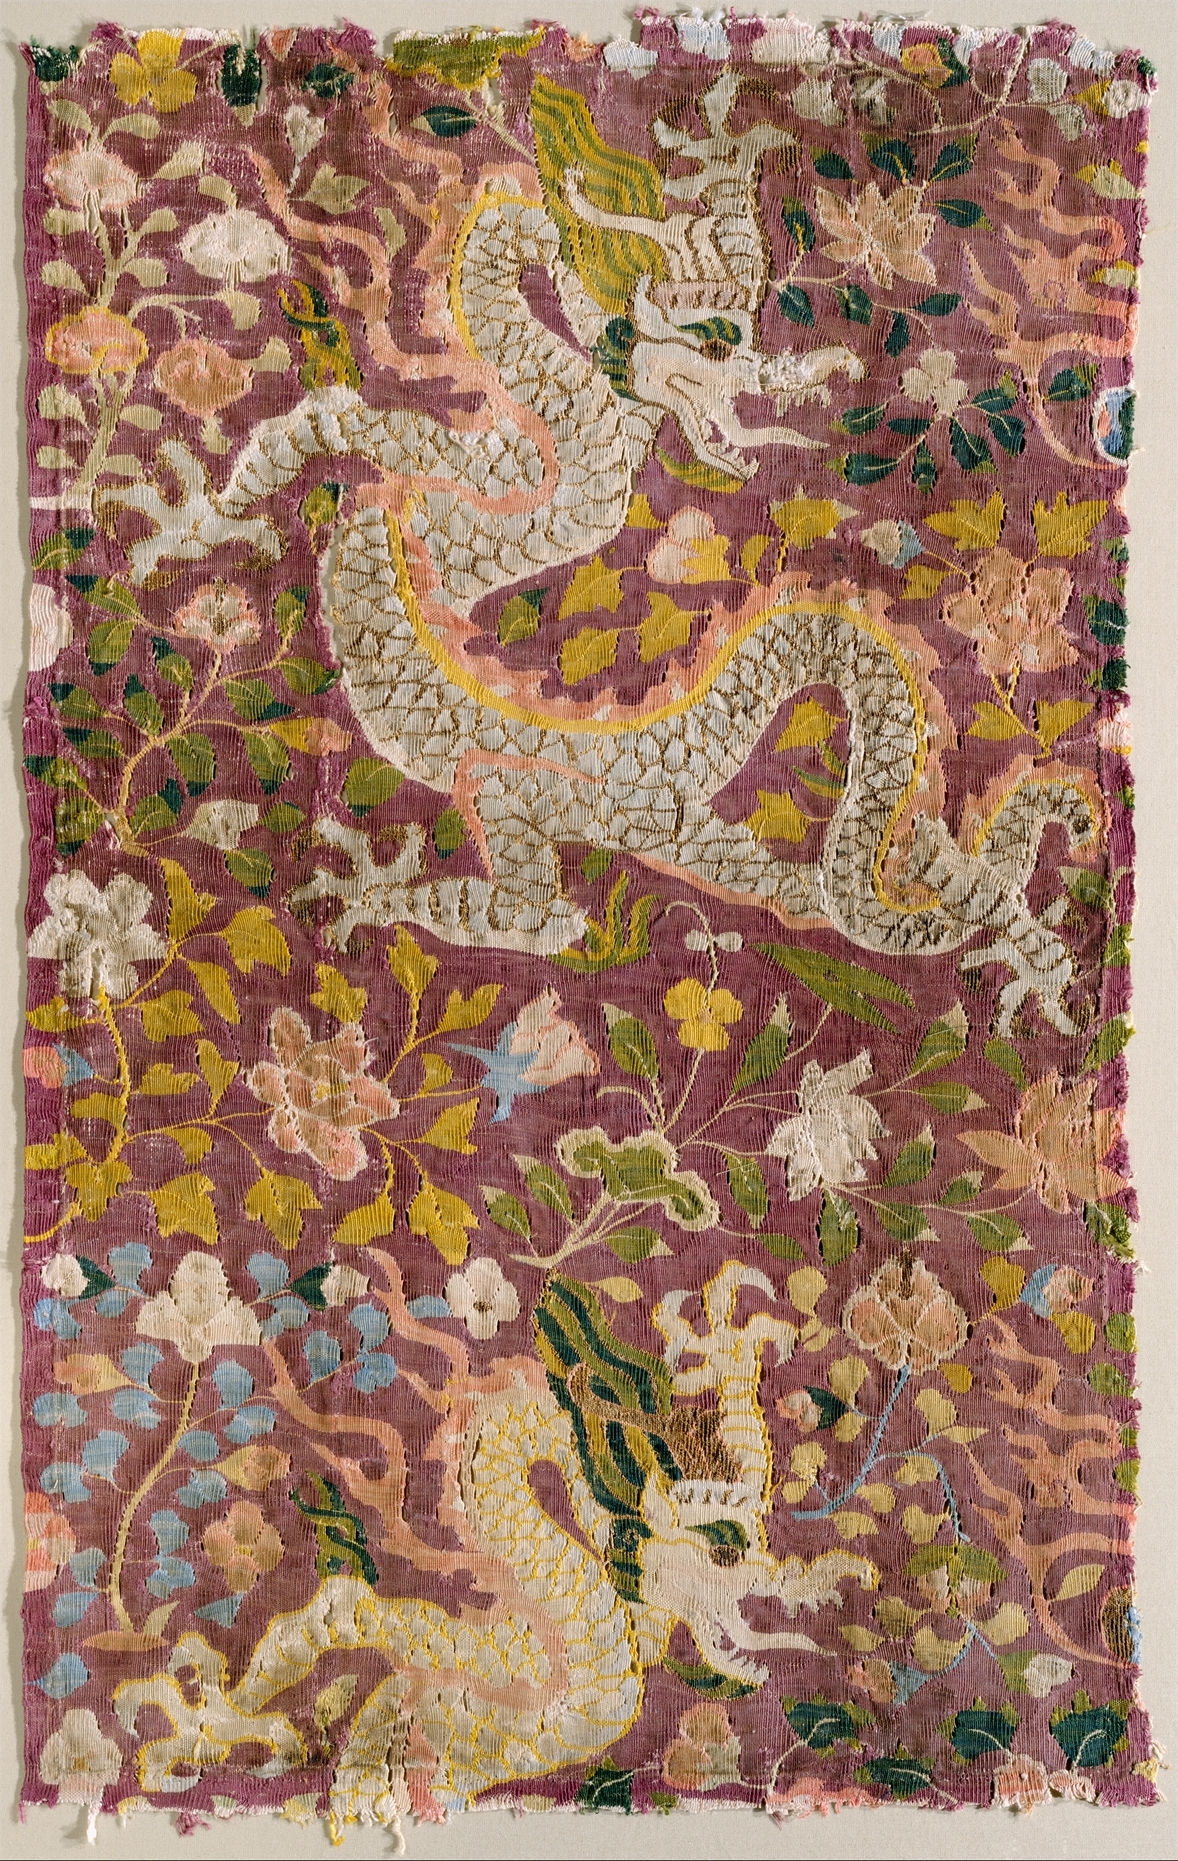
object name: panel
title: Tapestry with Dragons and Flowers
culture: eastern central asian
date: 1001-1200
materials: silk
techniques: tapestry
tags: dragons,flowers